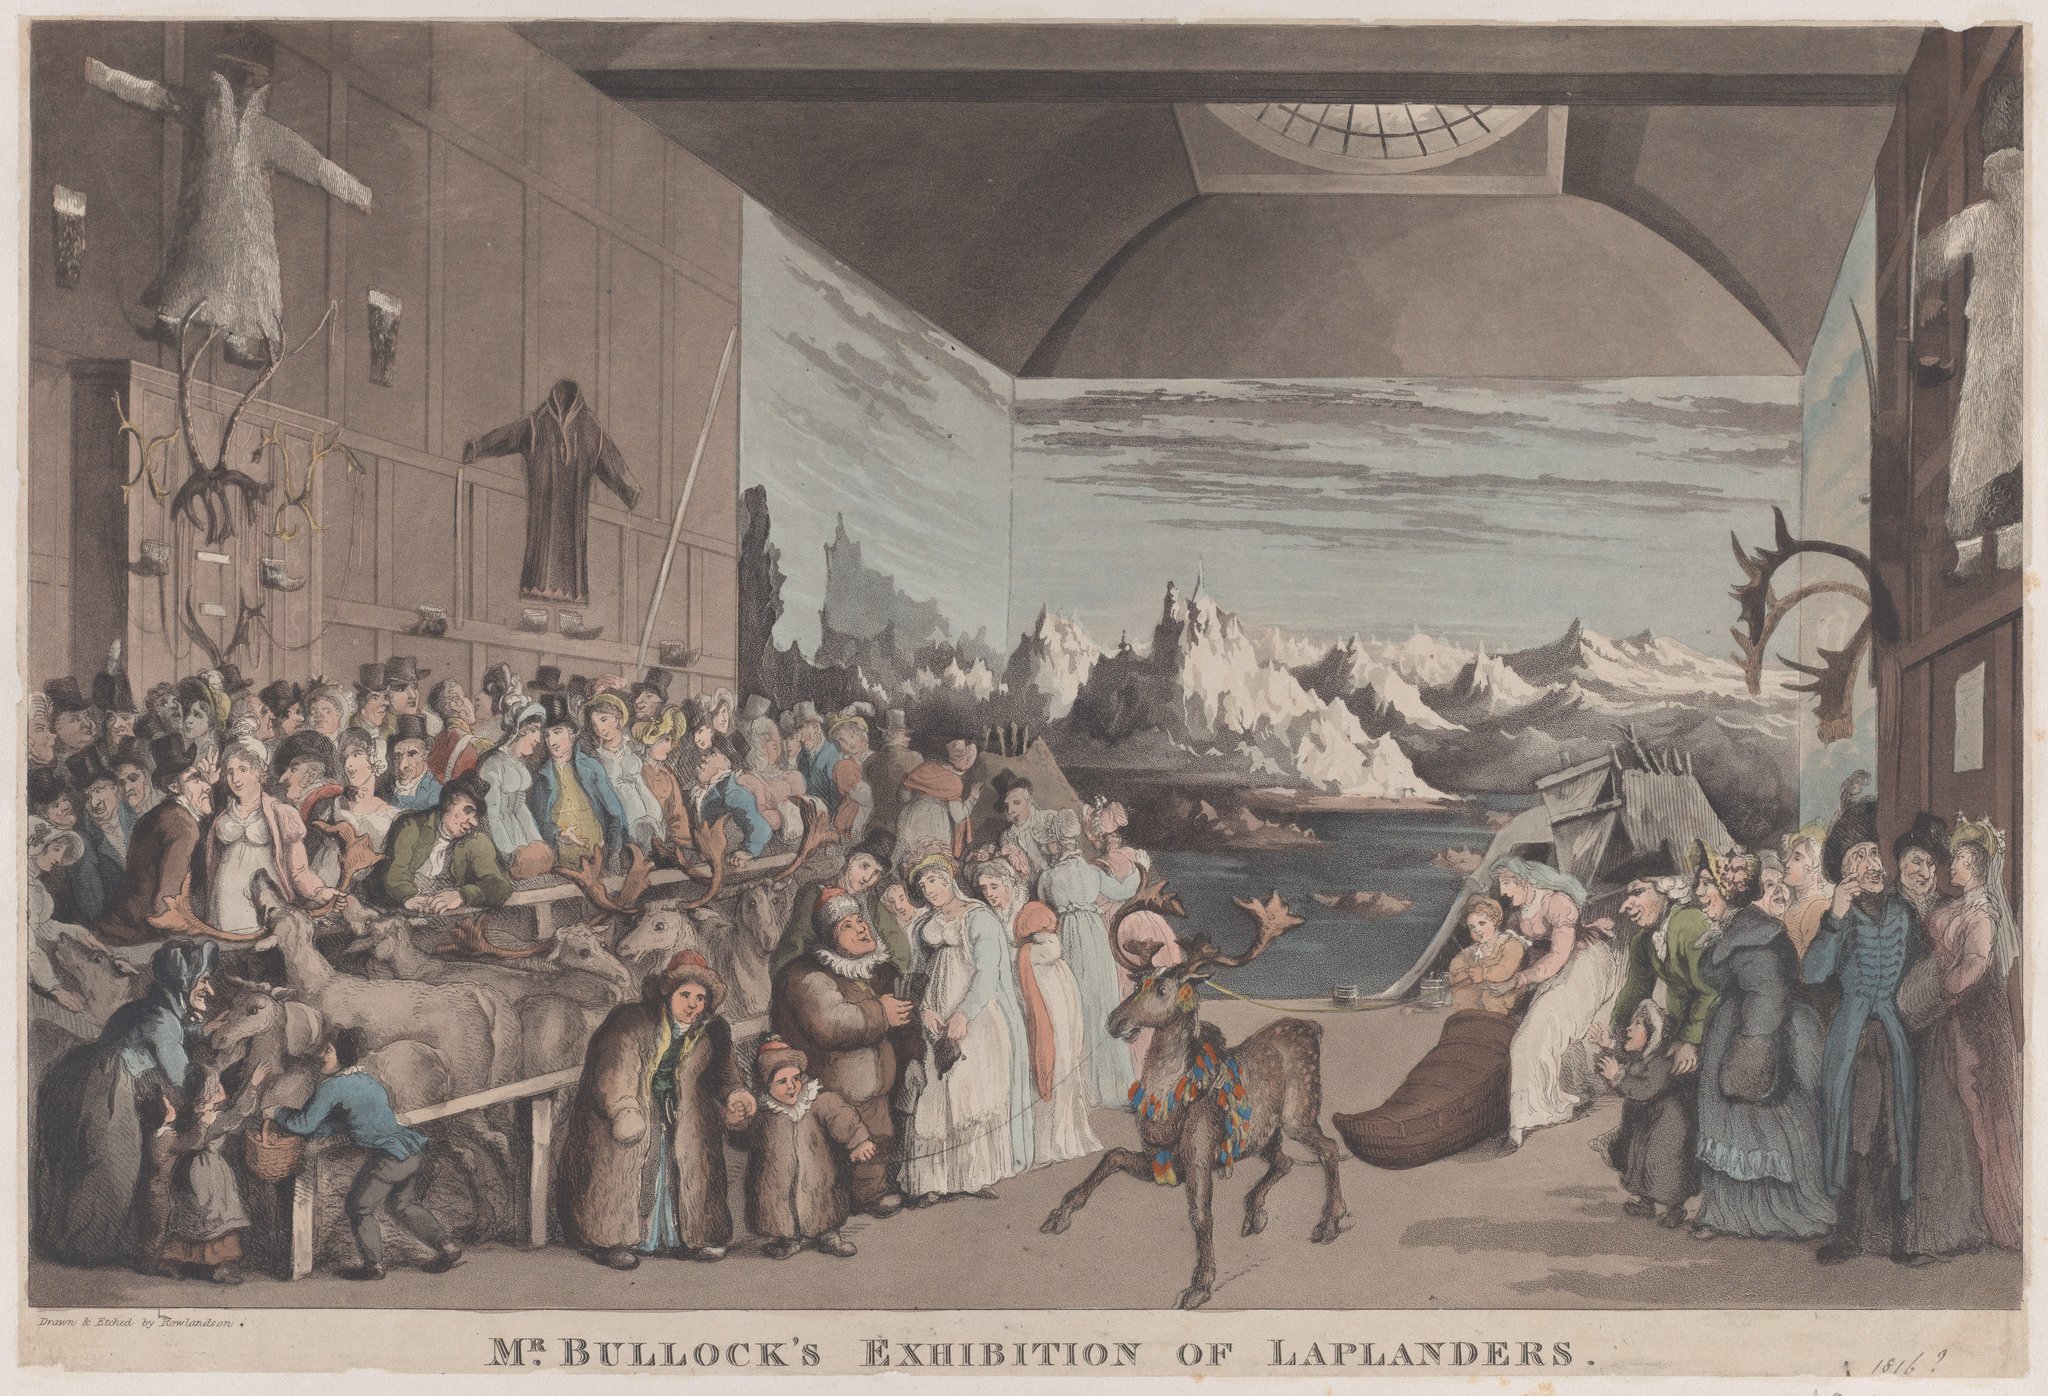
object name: print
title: Mr. Bullock's Exhibition of Laplanders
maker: thomas rowlandson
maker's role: artist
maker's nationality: british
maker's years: 1757-1827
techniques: aquatint, etching, hand coloring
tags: animals,spectators